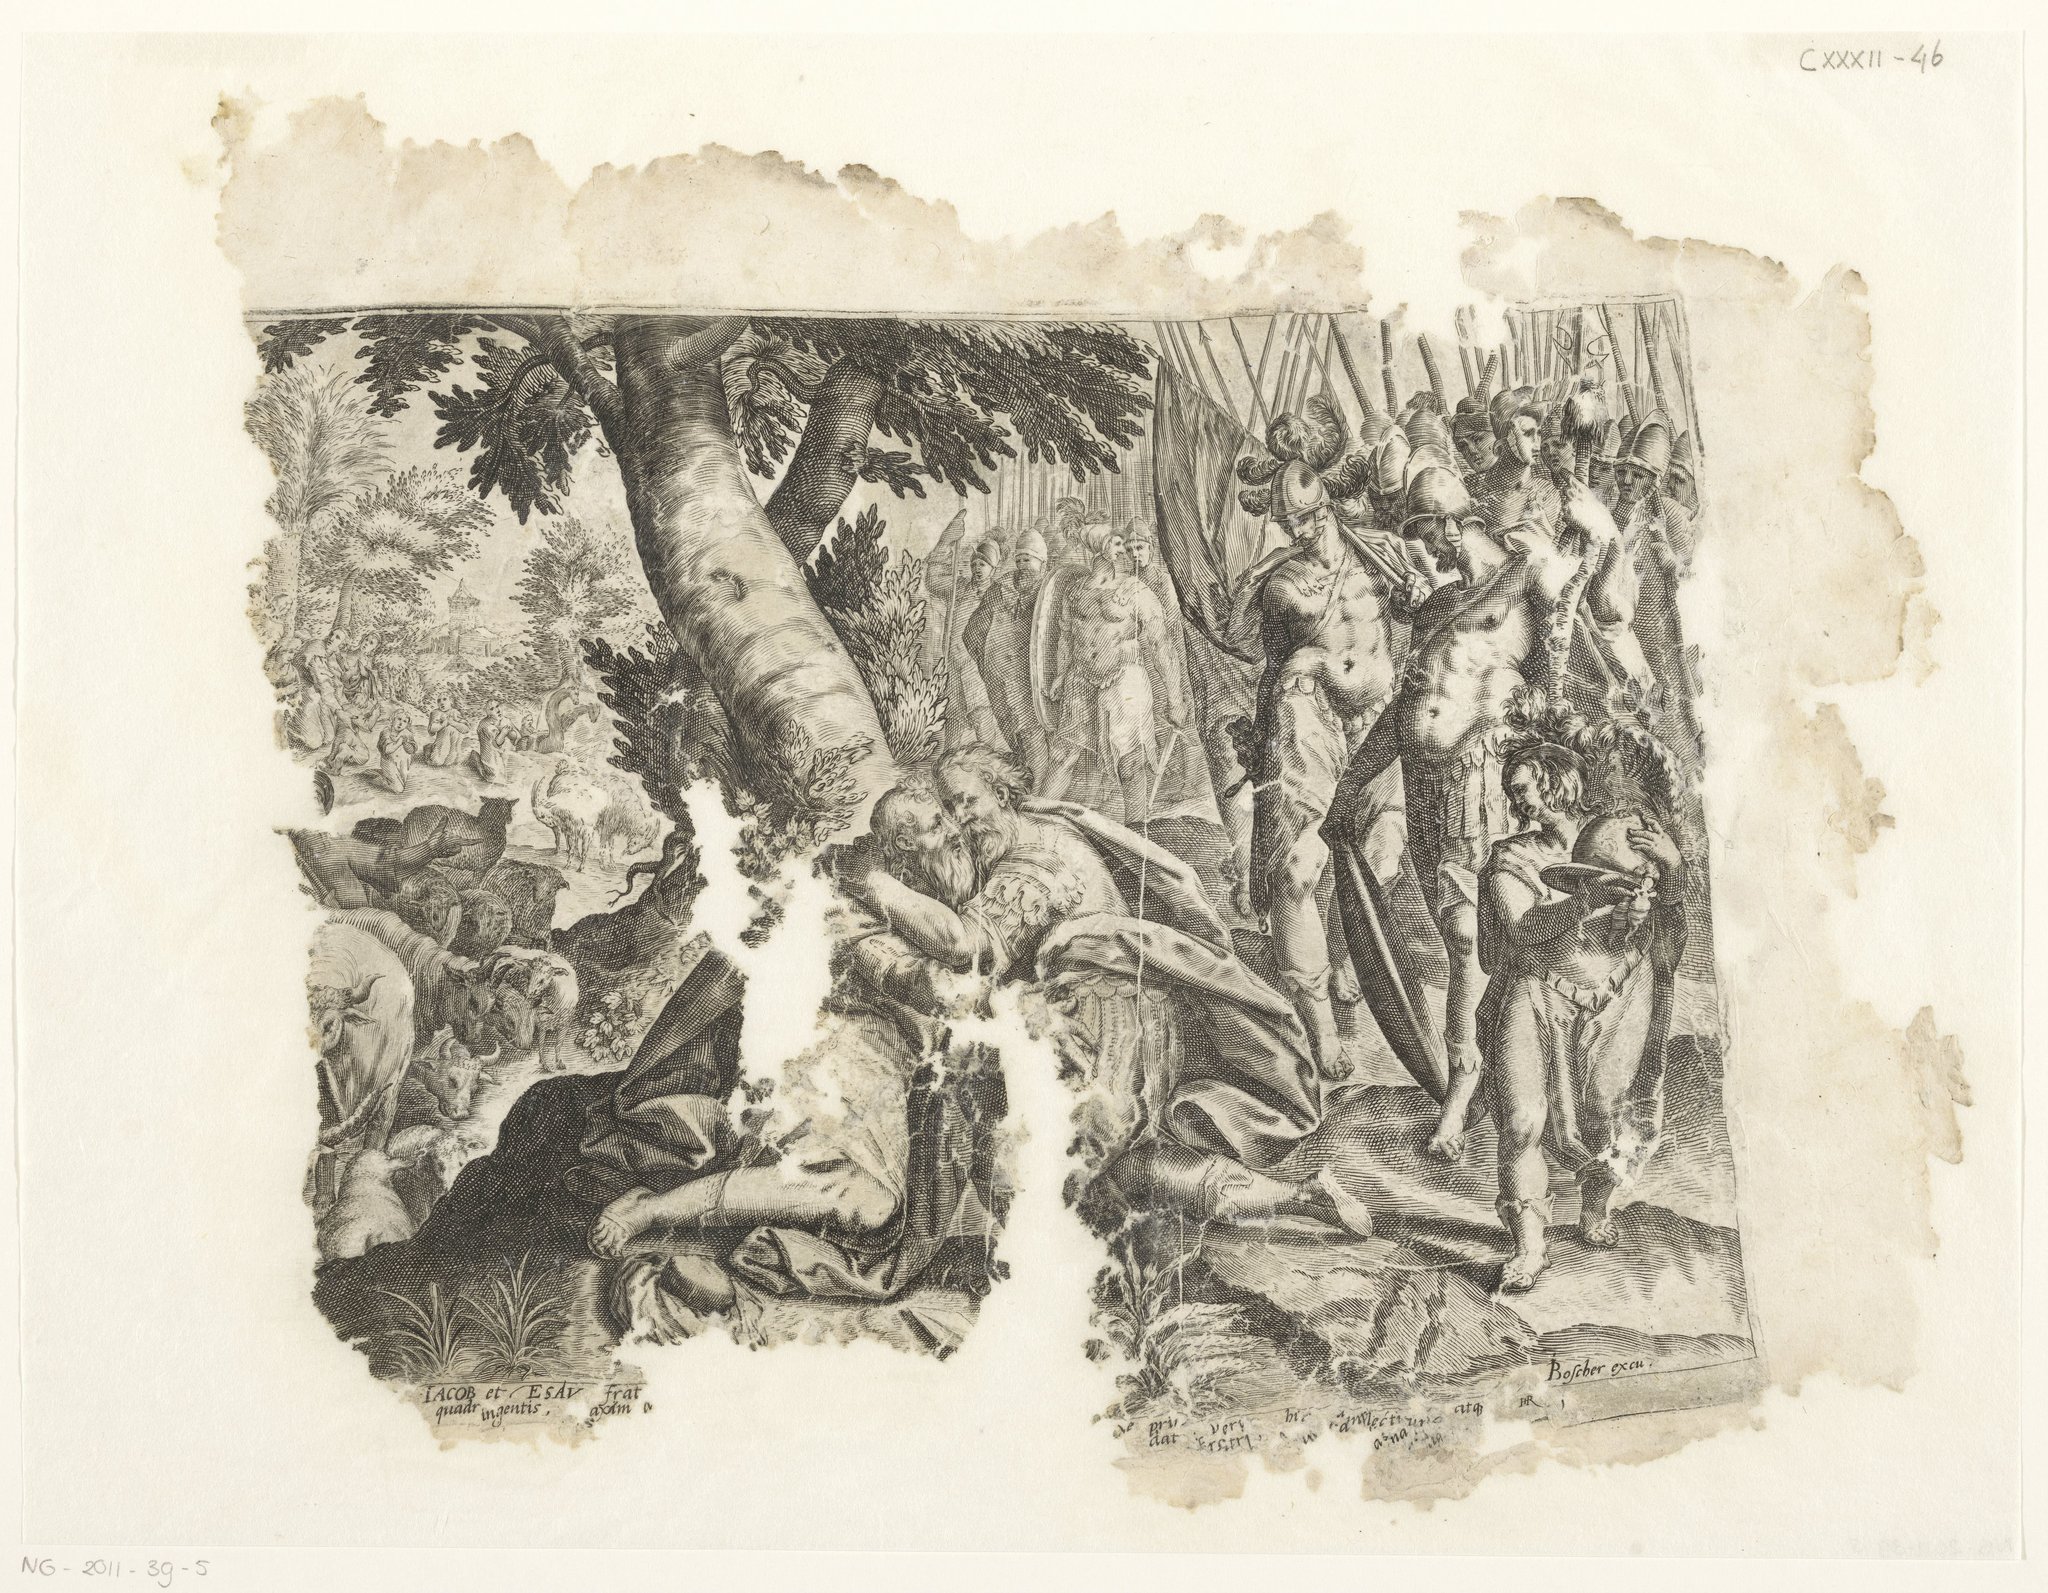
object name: print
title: Verzoening van Jakob en Esau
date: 1580-1596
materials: paper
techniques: engraving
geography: northern netherlands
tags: the meeting between esau and jacob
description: Tot dusverre was deze prent alleen bekend in een latere editie met het adres van C.J. Visscher in het door hem uitgegeven Theatrum Biblicum uit 1643, zie RP-P-1976-30-39. De prenten in de Nova Zembla collectie zijn tijdens een expeditie van Willem Barendsz en Jacob van Heemskerk in 1596-1597 noodgedwongen in het winterkamp, het ‘Behouden Huis’, op het eiland achtergelaten. De prenten waren in één of meerdere stapels als handelswaar meegenomen vanuit Amsterdam. Bijna drie eeuwen later, in 1871, keerde de Noor Elling Carlsen terug naar Nova Zembla en vond daar de restanten van het ‘Behouden Huis, inclusief een groot deel van de inventaris. Een deel van de prenten, in de vorm van aaneengekoekte kluiten, werd toen ook teruggevonden. De papierkluiten waren soms op meerdere plekken gebroken. Tussen 1975-1979 zijn de prenten van elkaar gescheiden. Dit leverde in totaal ca. 1000 fragmenten van ca. 400 afdrukken van ca. 150 verschillende prenten op. Voor zover mogelijk zijn de fragmenten samengevoegd en zijn de prenten gereconstrueerd.